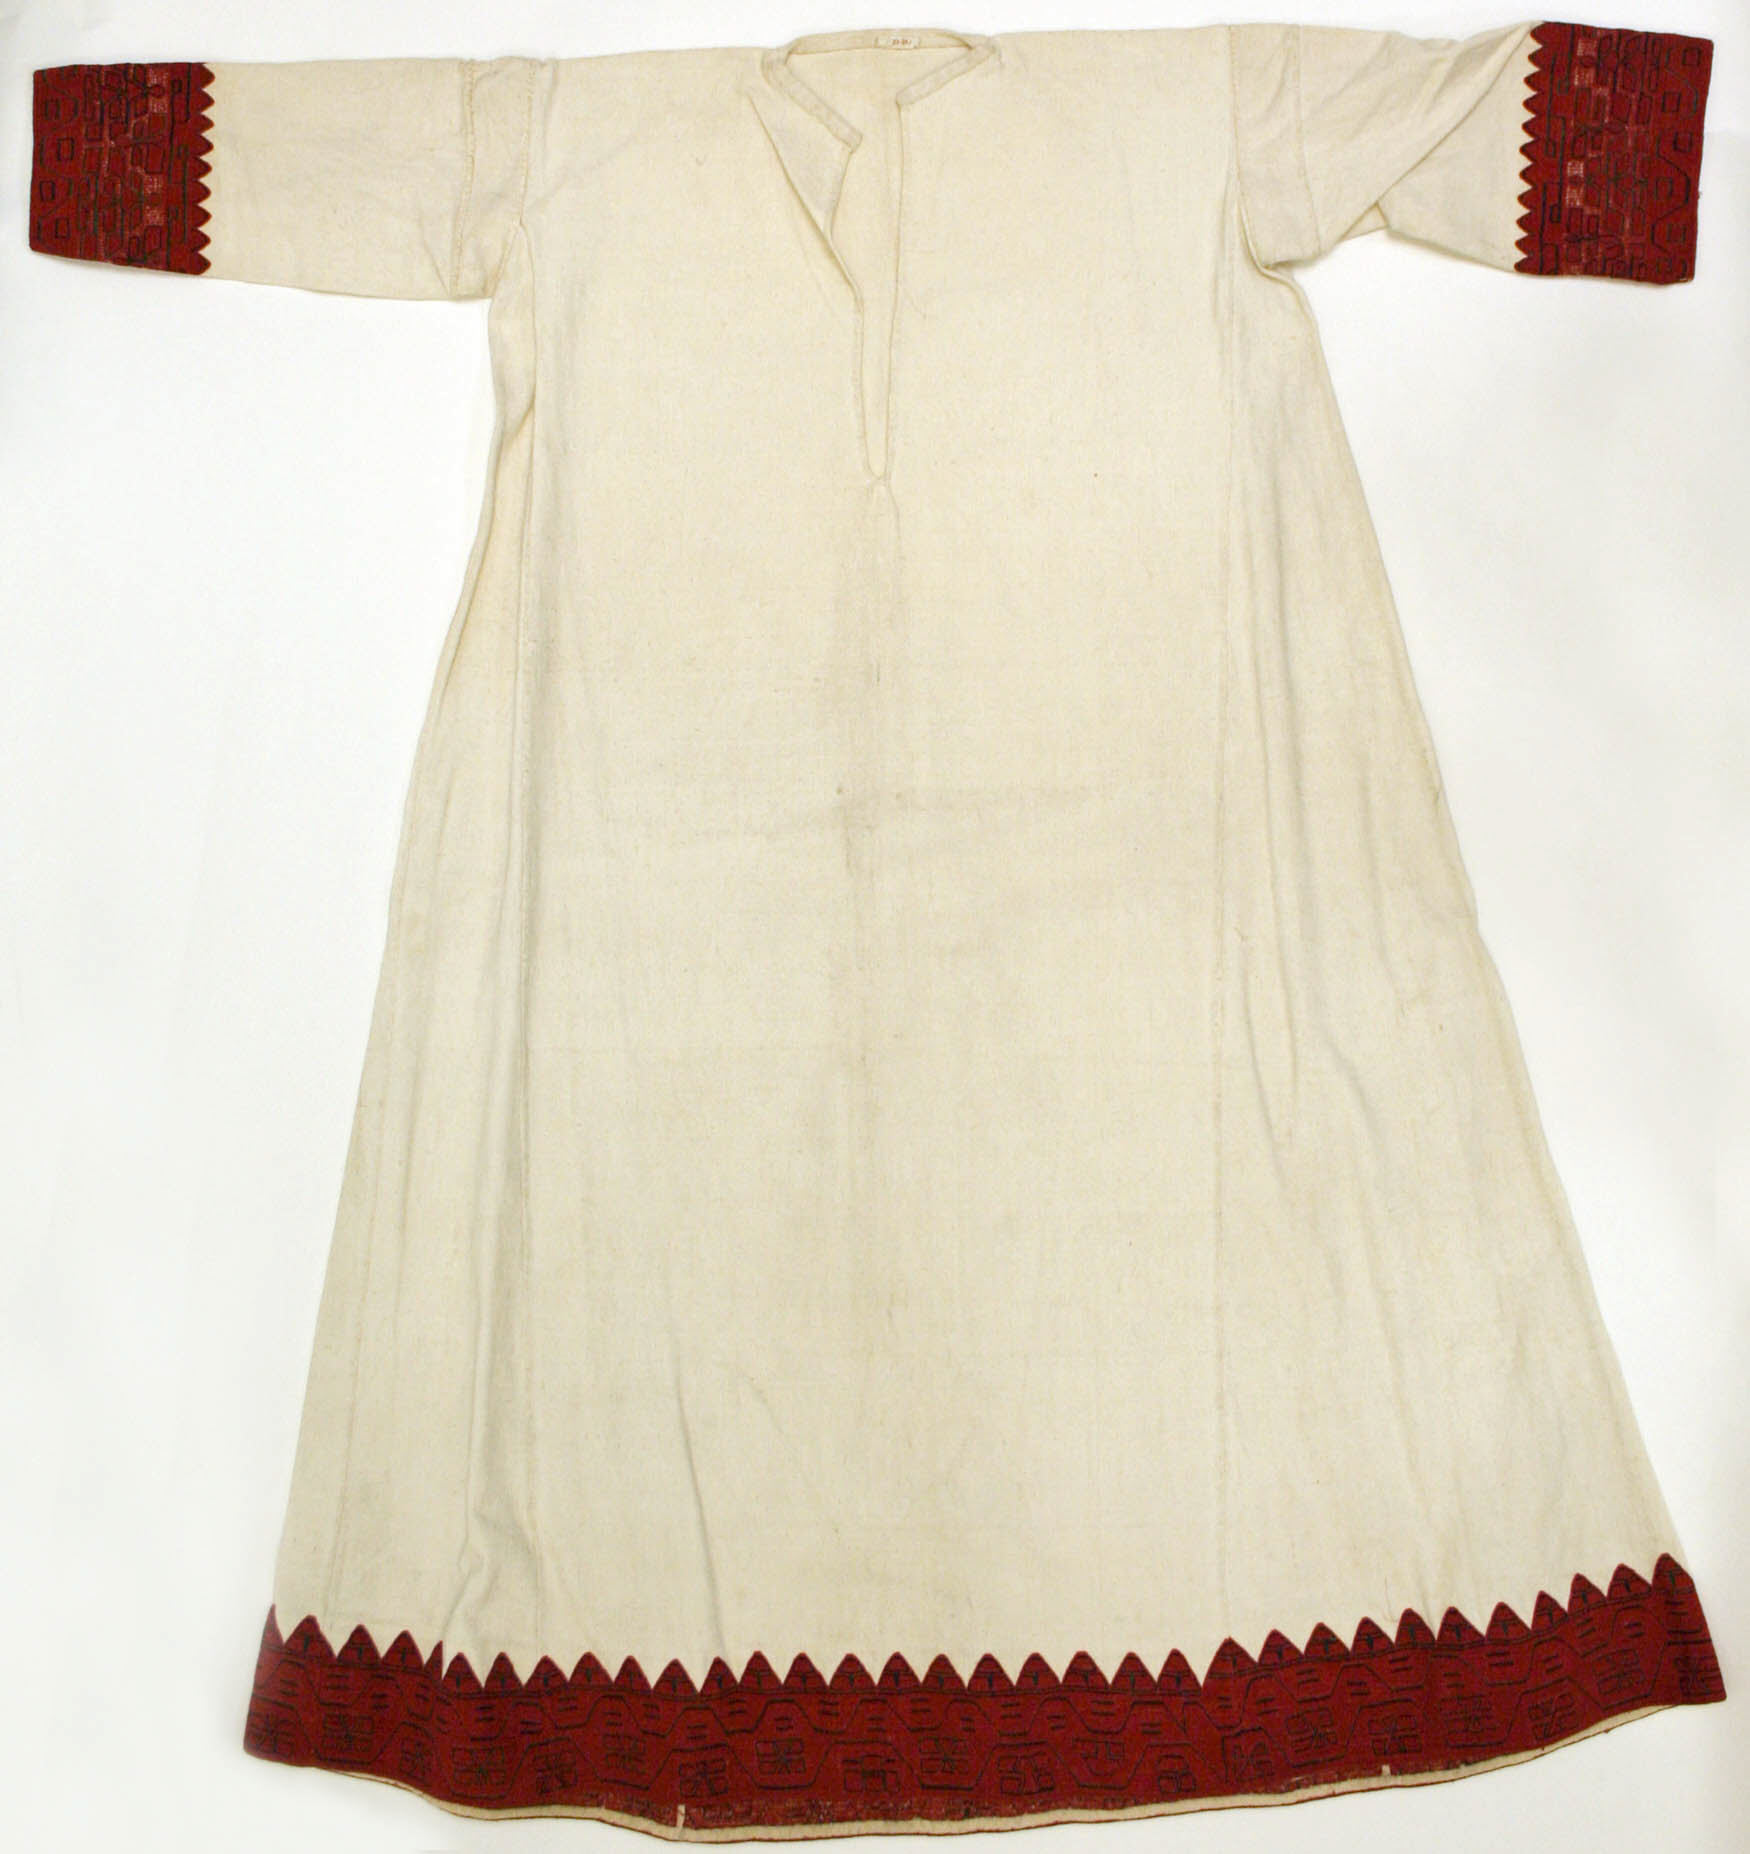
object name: shirt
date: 1801-1900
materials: cotton